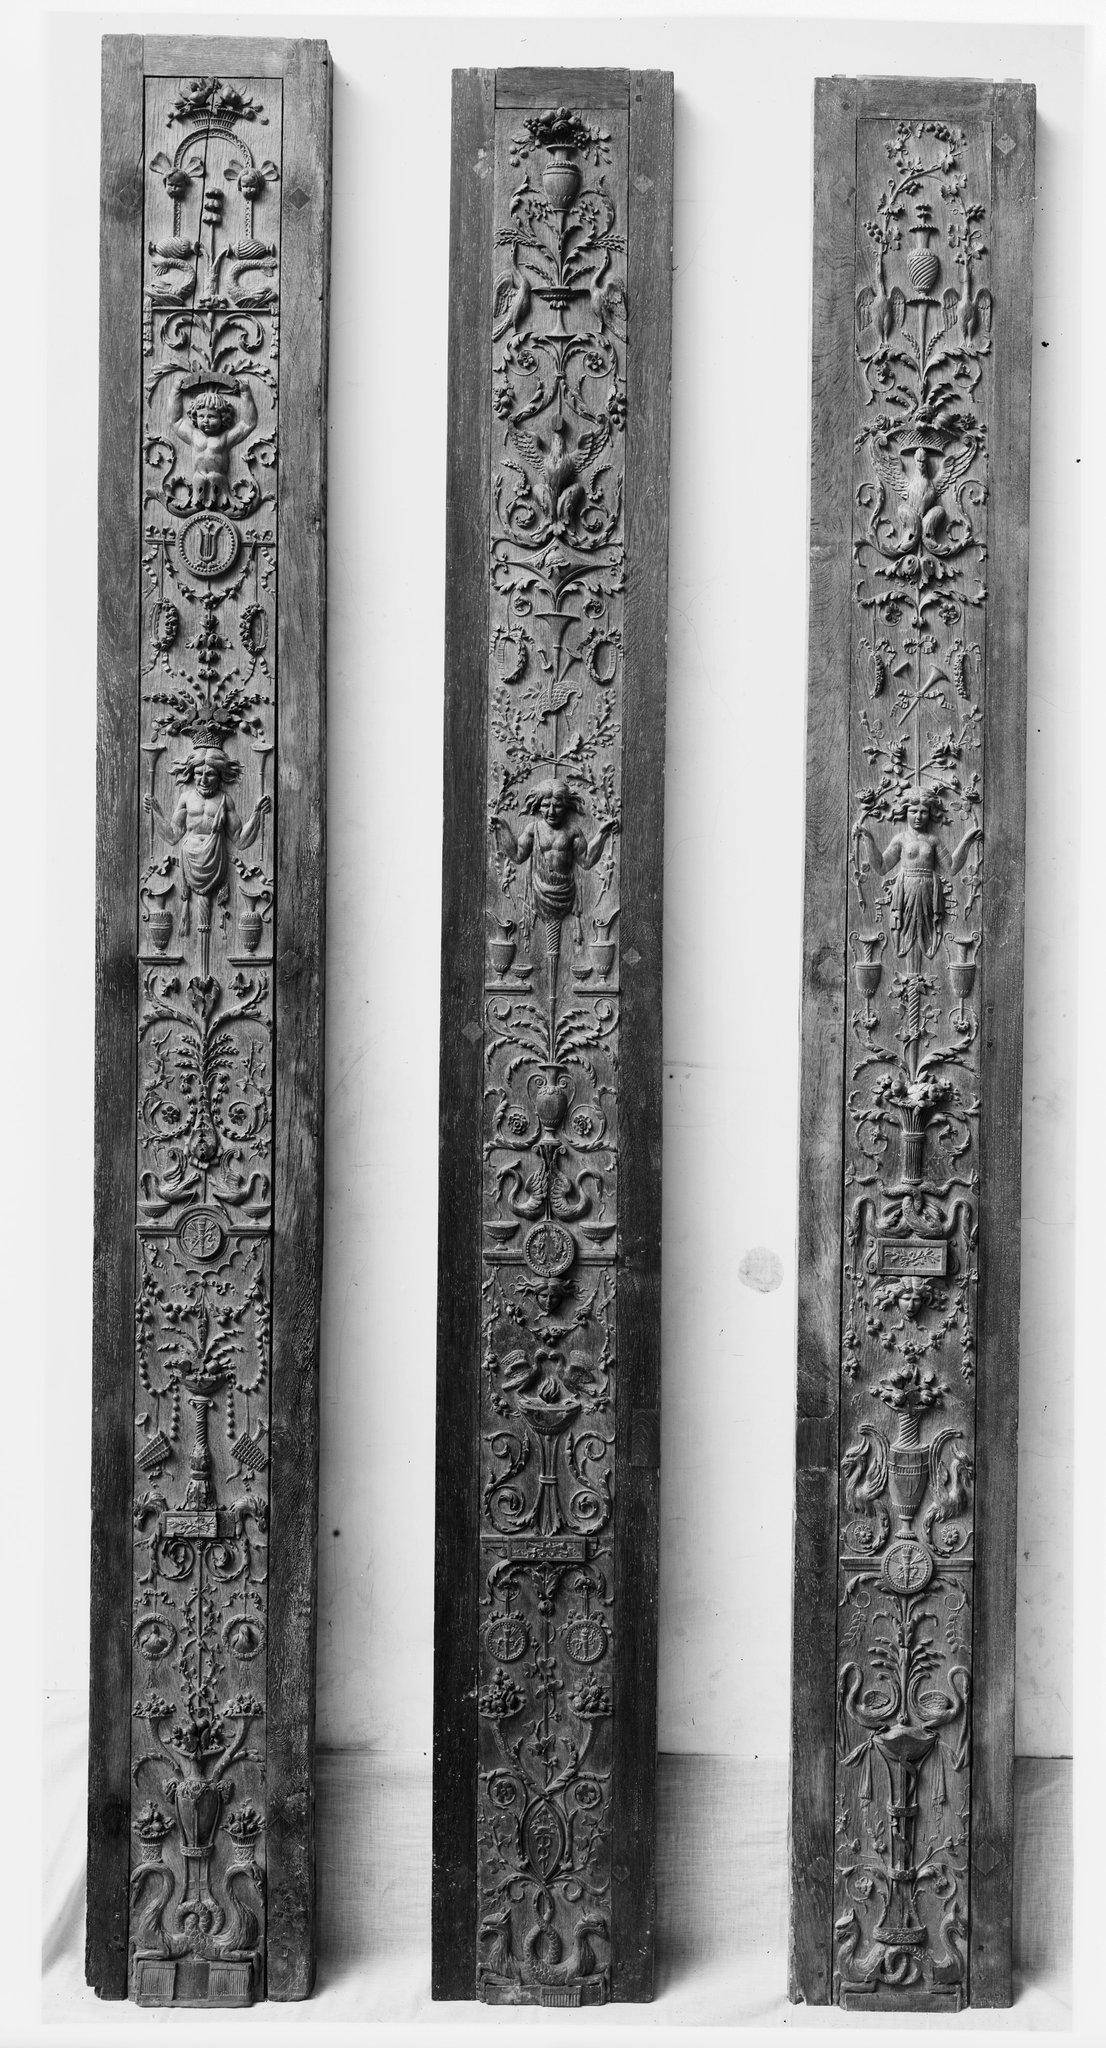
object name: pilaster panel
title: Pilaster panel (part of a set of eight)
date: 1701-1800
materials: wood